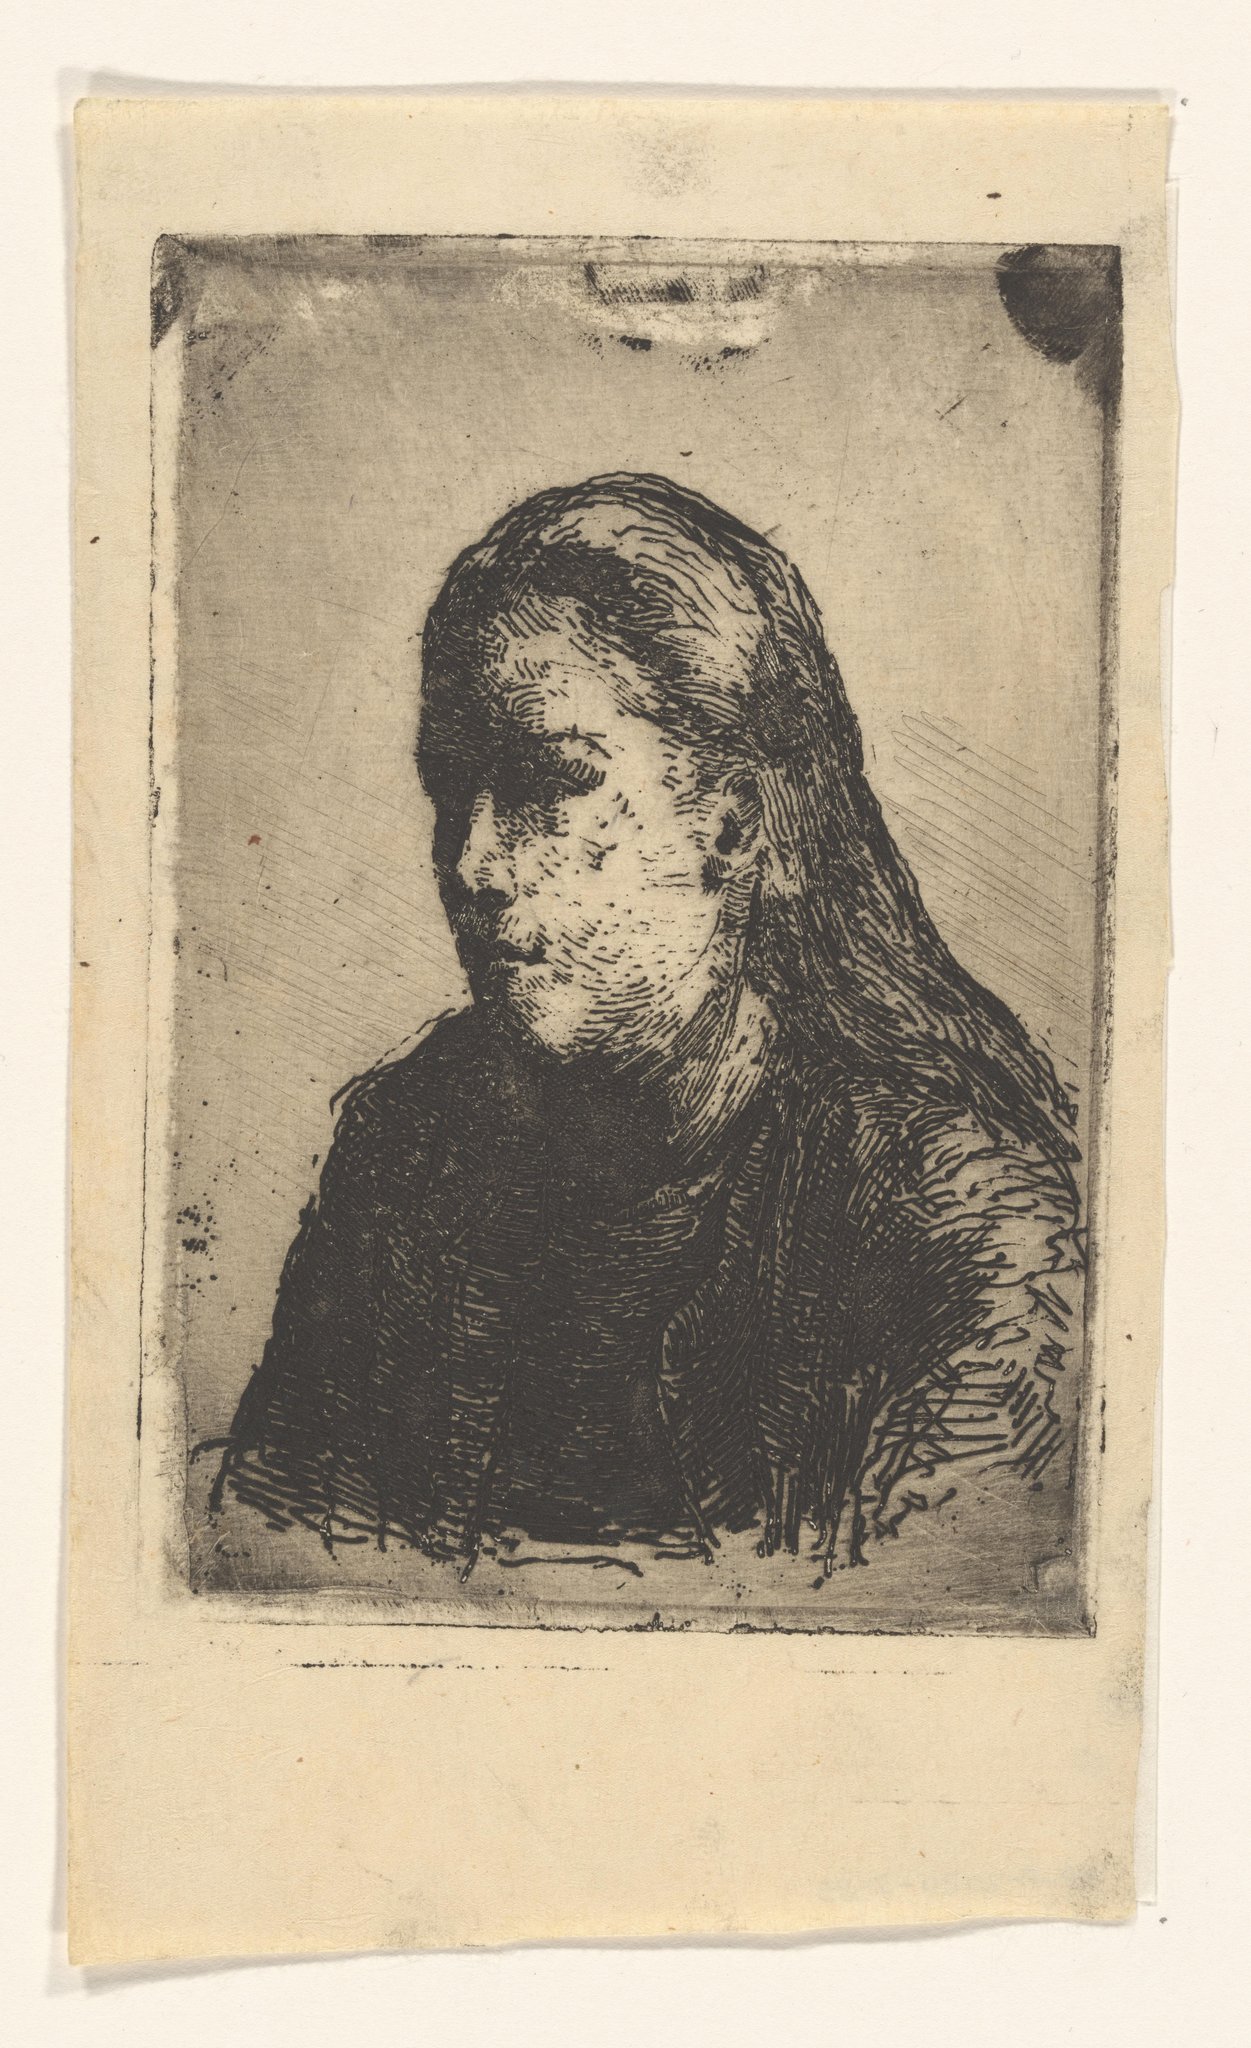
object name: print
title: Portret van meisje met lang haar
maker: johanna behrend-croiset van der kop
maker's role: draughtsman, painter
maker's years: 1861-1943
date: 1880-1900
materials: paper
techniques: etching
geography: netherlands